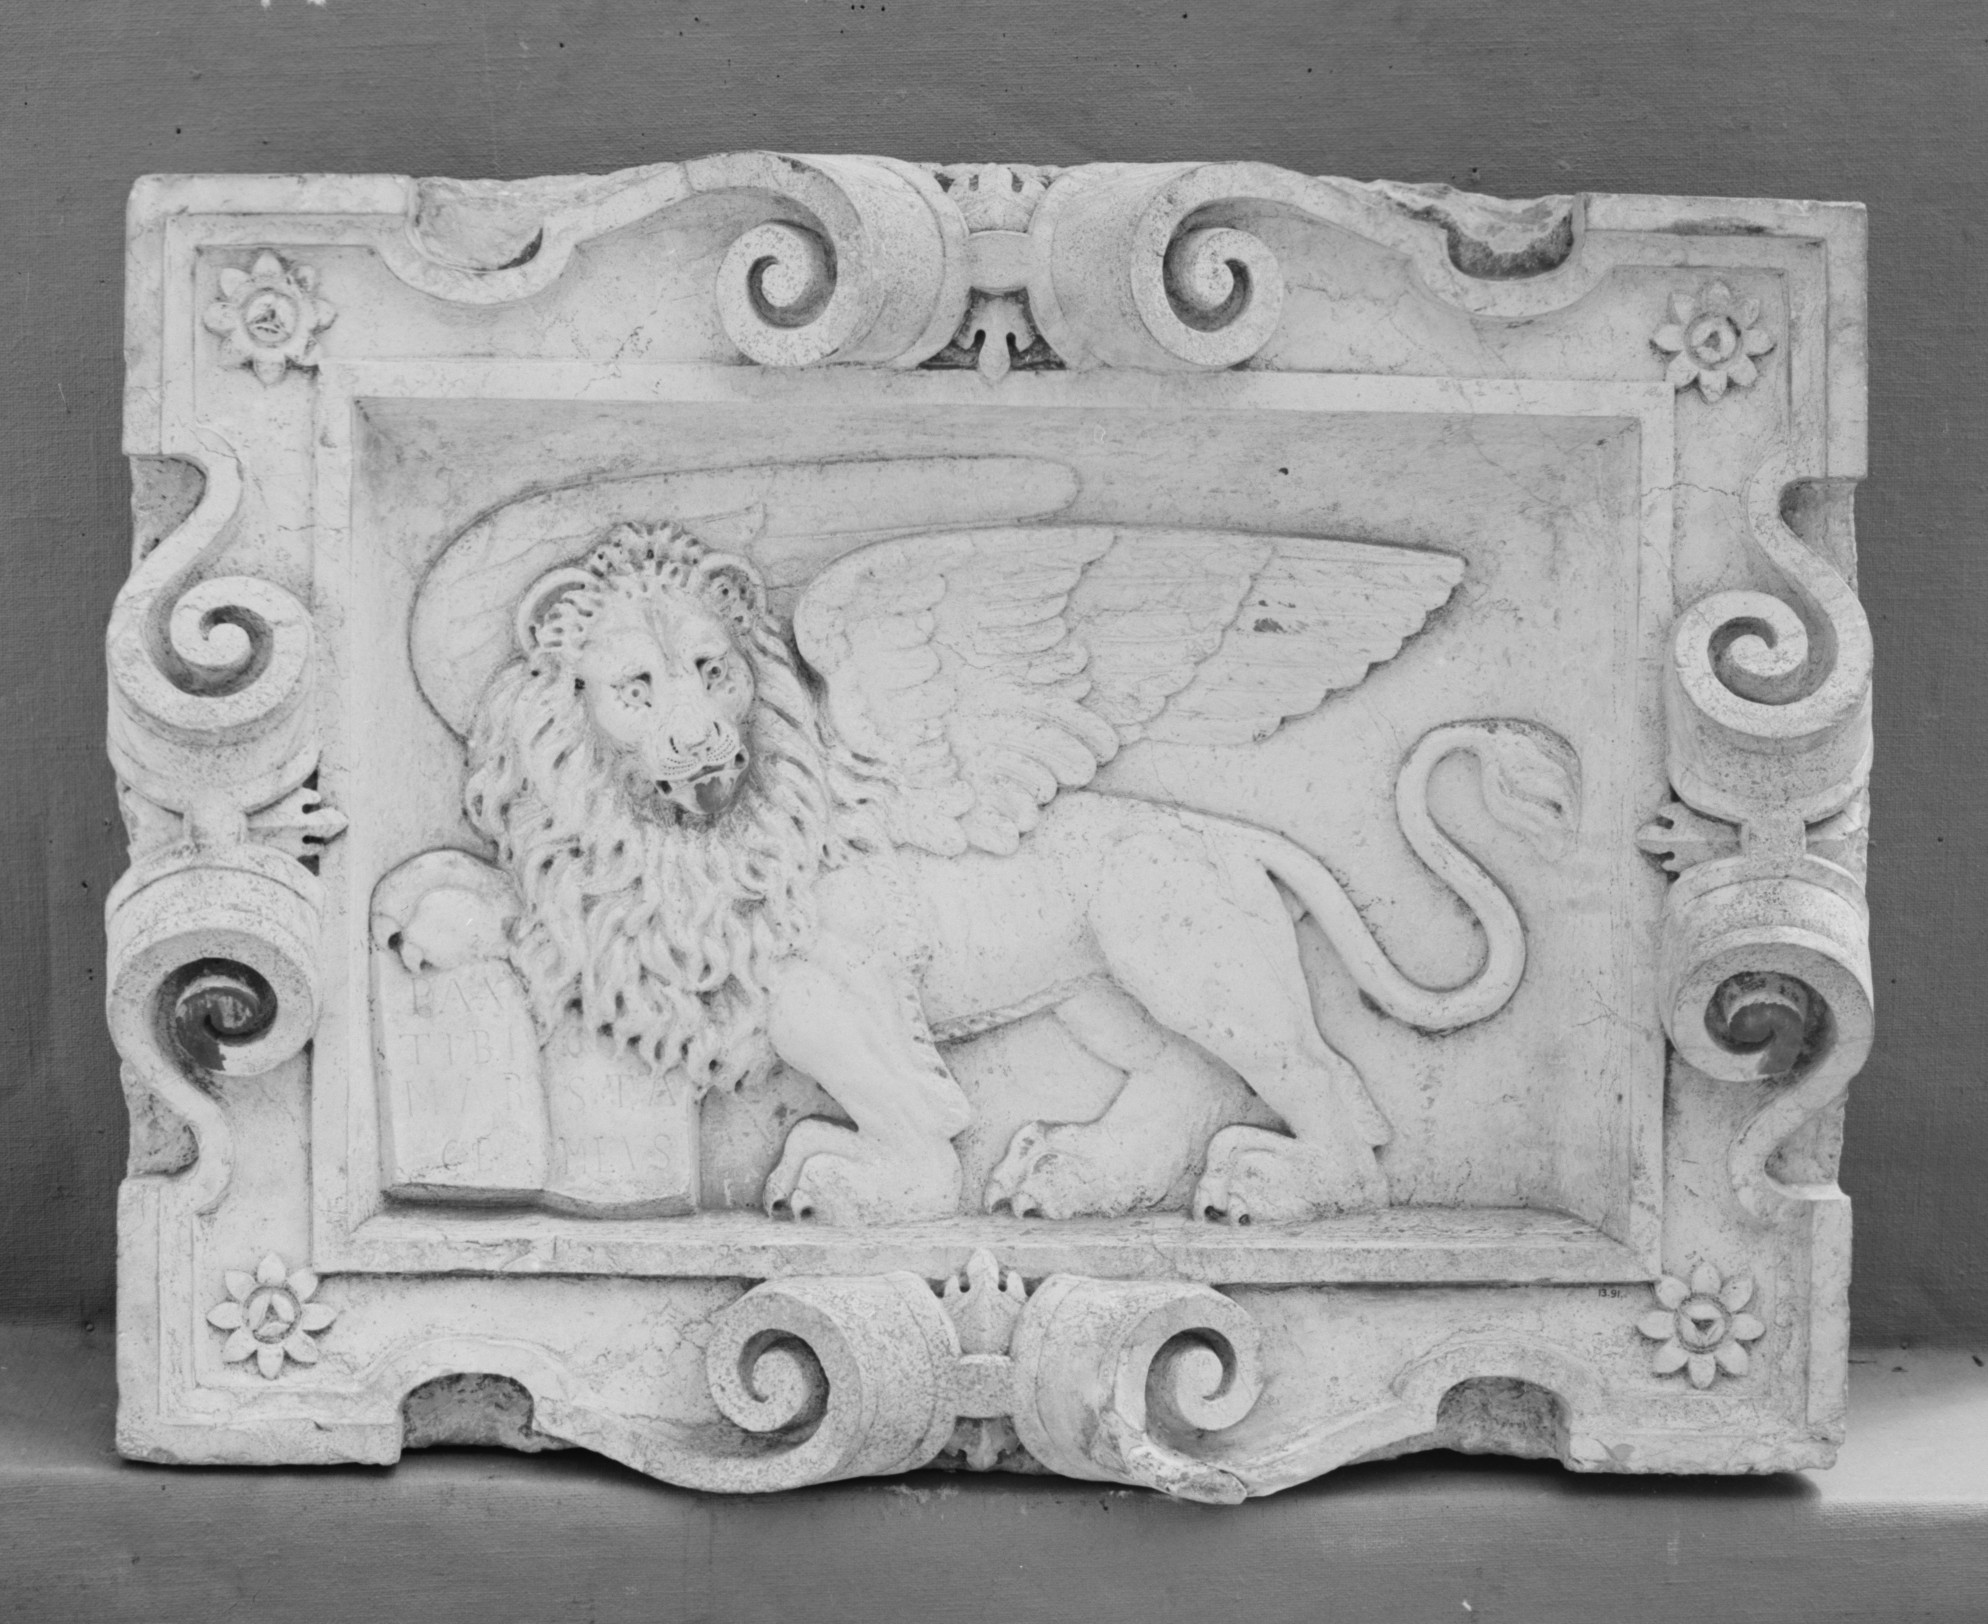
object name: relief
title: Lion of Saint Mark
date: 1550-1600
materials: limestone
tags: lions